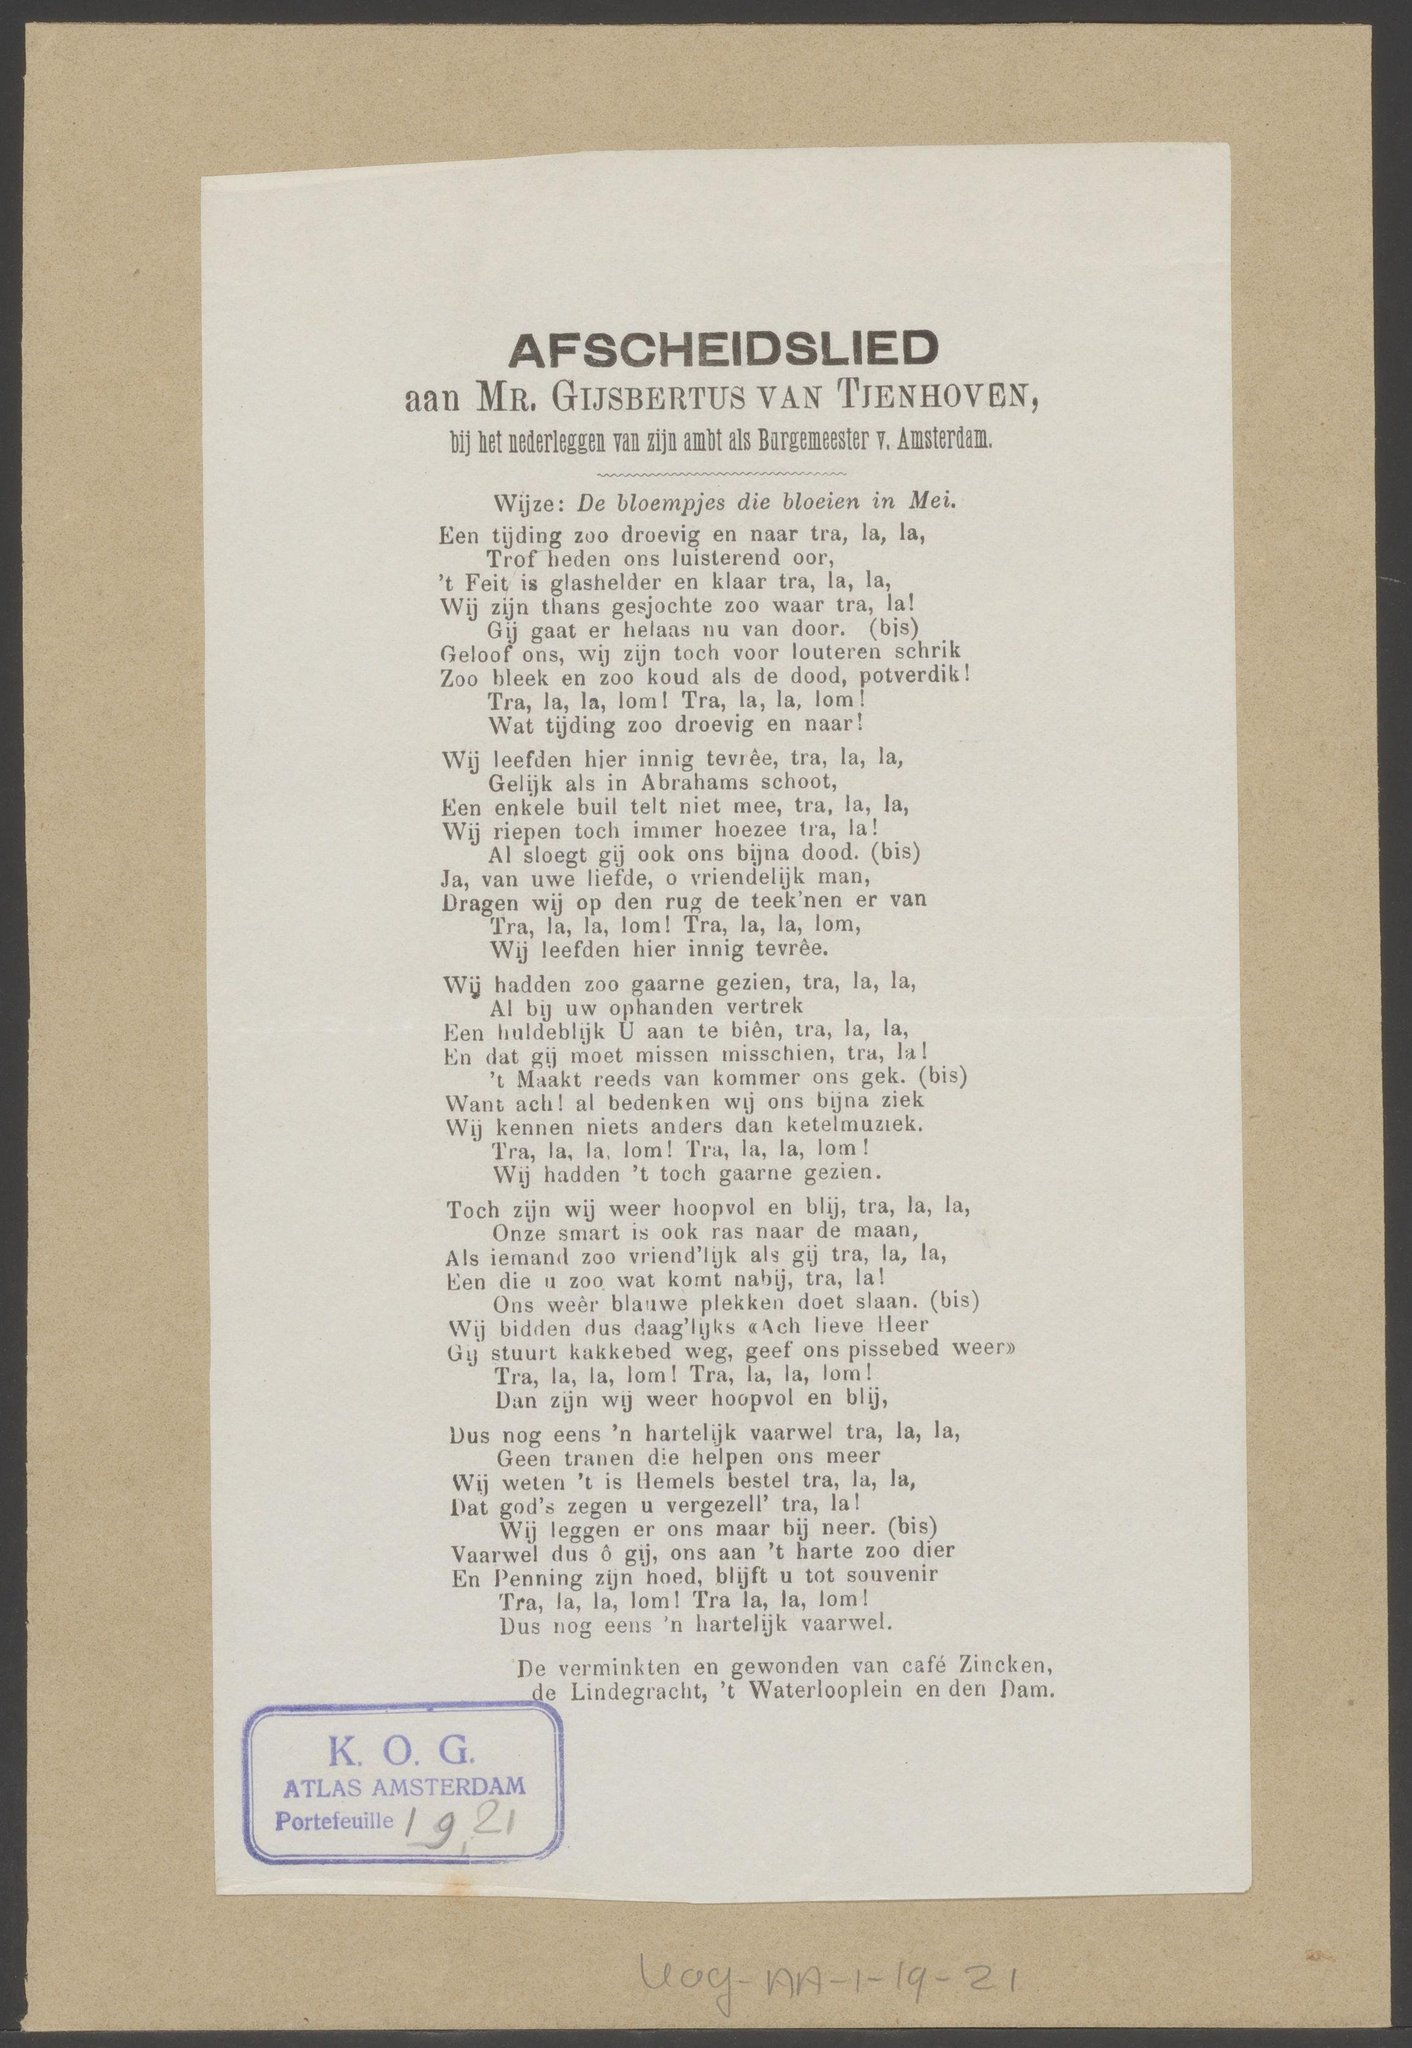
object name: text sheet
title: Afscheidslied ter gelegenheid van het aftreden van Gijsbert van Tienhoven als burgemeester van Amsterdam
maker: Anonymous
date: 1891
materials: paper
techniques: letterpress printing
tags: mayor, gijsbert van tienhoven, mayor, burgomaster, voluntary abdication (of a ruler), amsterdam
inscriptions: collector's mark: ‘19,21’ Lugt 1641b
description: Onderwerpsrubriek binnen de Atlas Amsterdam: Herinneringen aan regeringsleden en hunne huisgezinnen [na 1800].